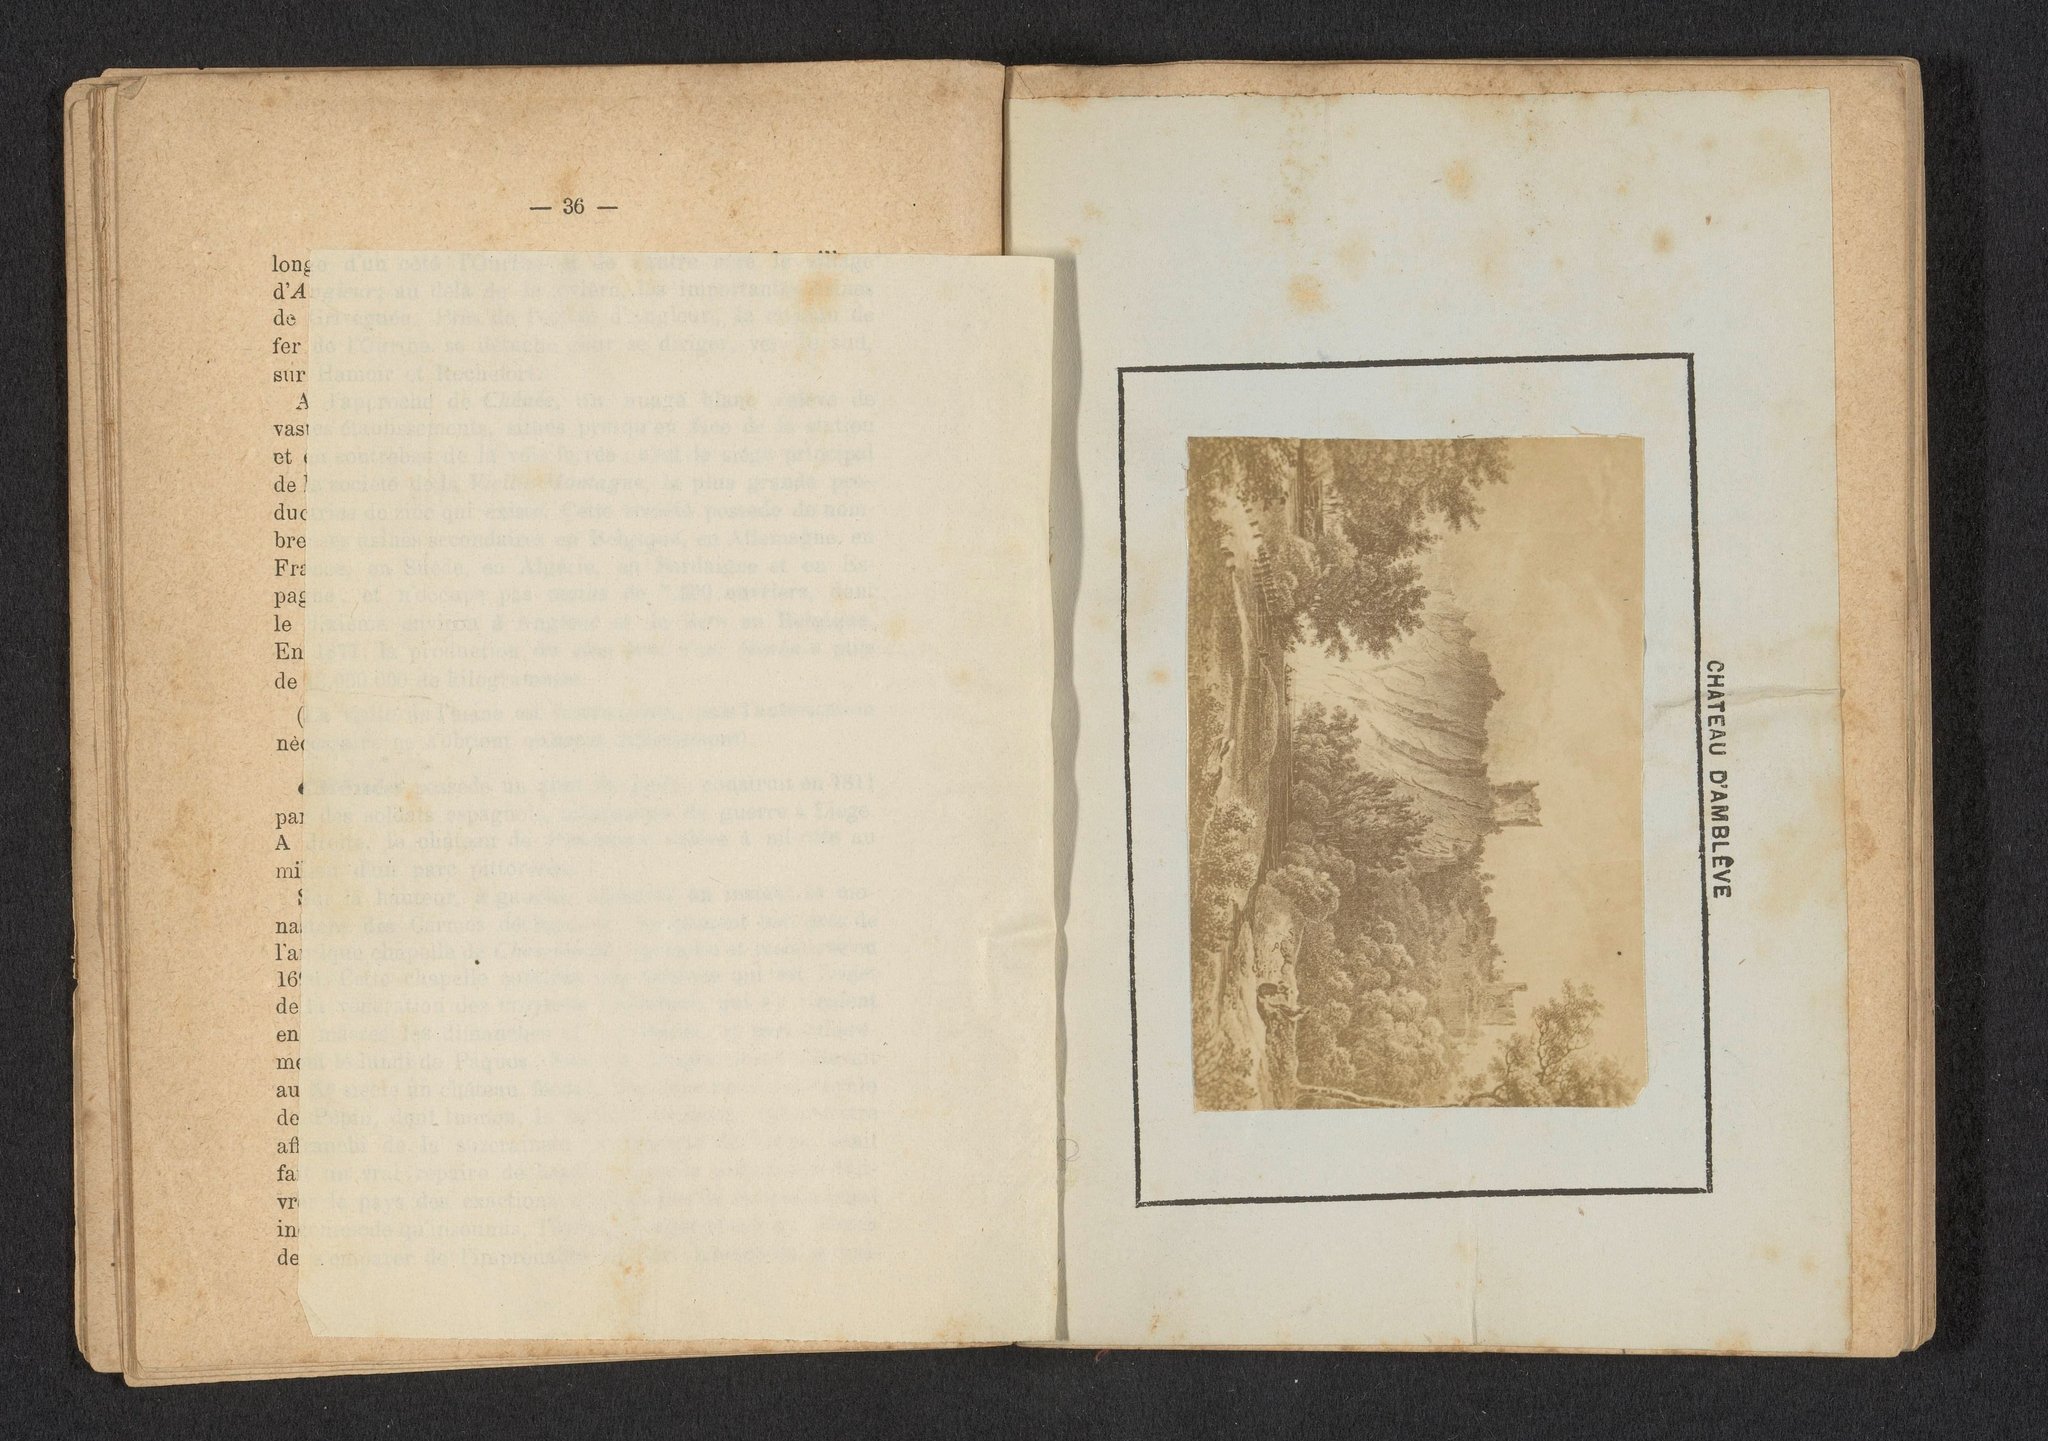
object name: page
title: Chateau d'Amblève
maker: Anonymous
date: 1876-1881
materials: photographic support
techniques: albumen print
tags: landscapes, castle